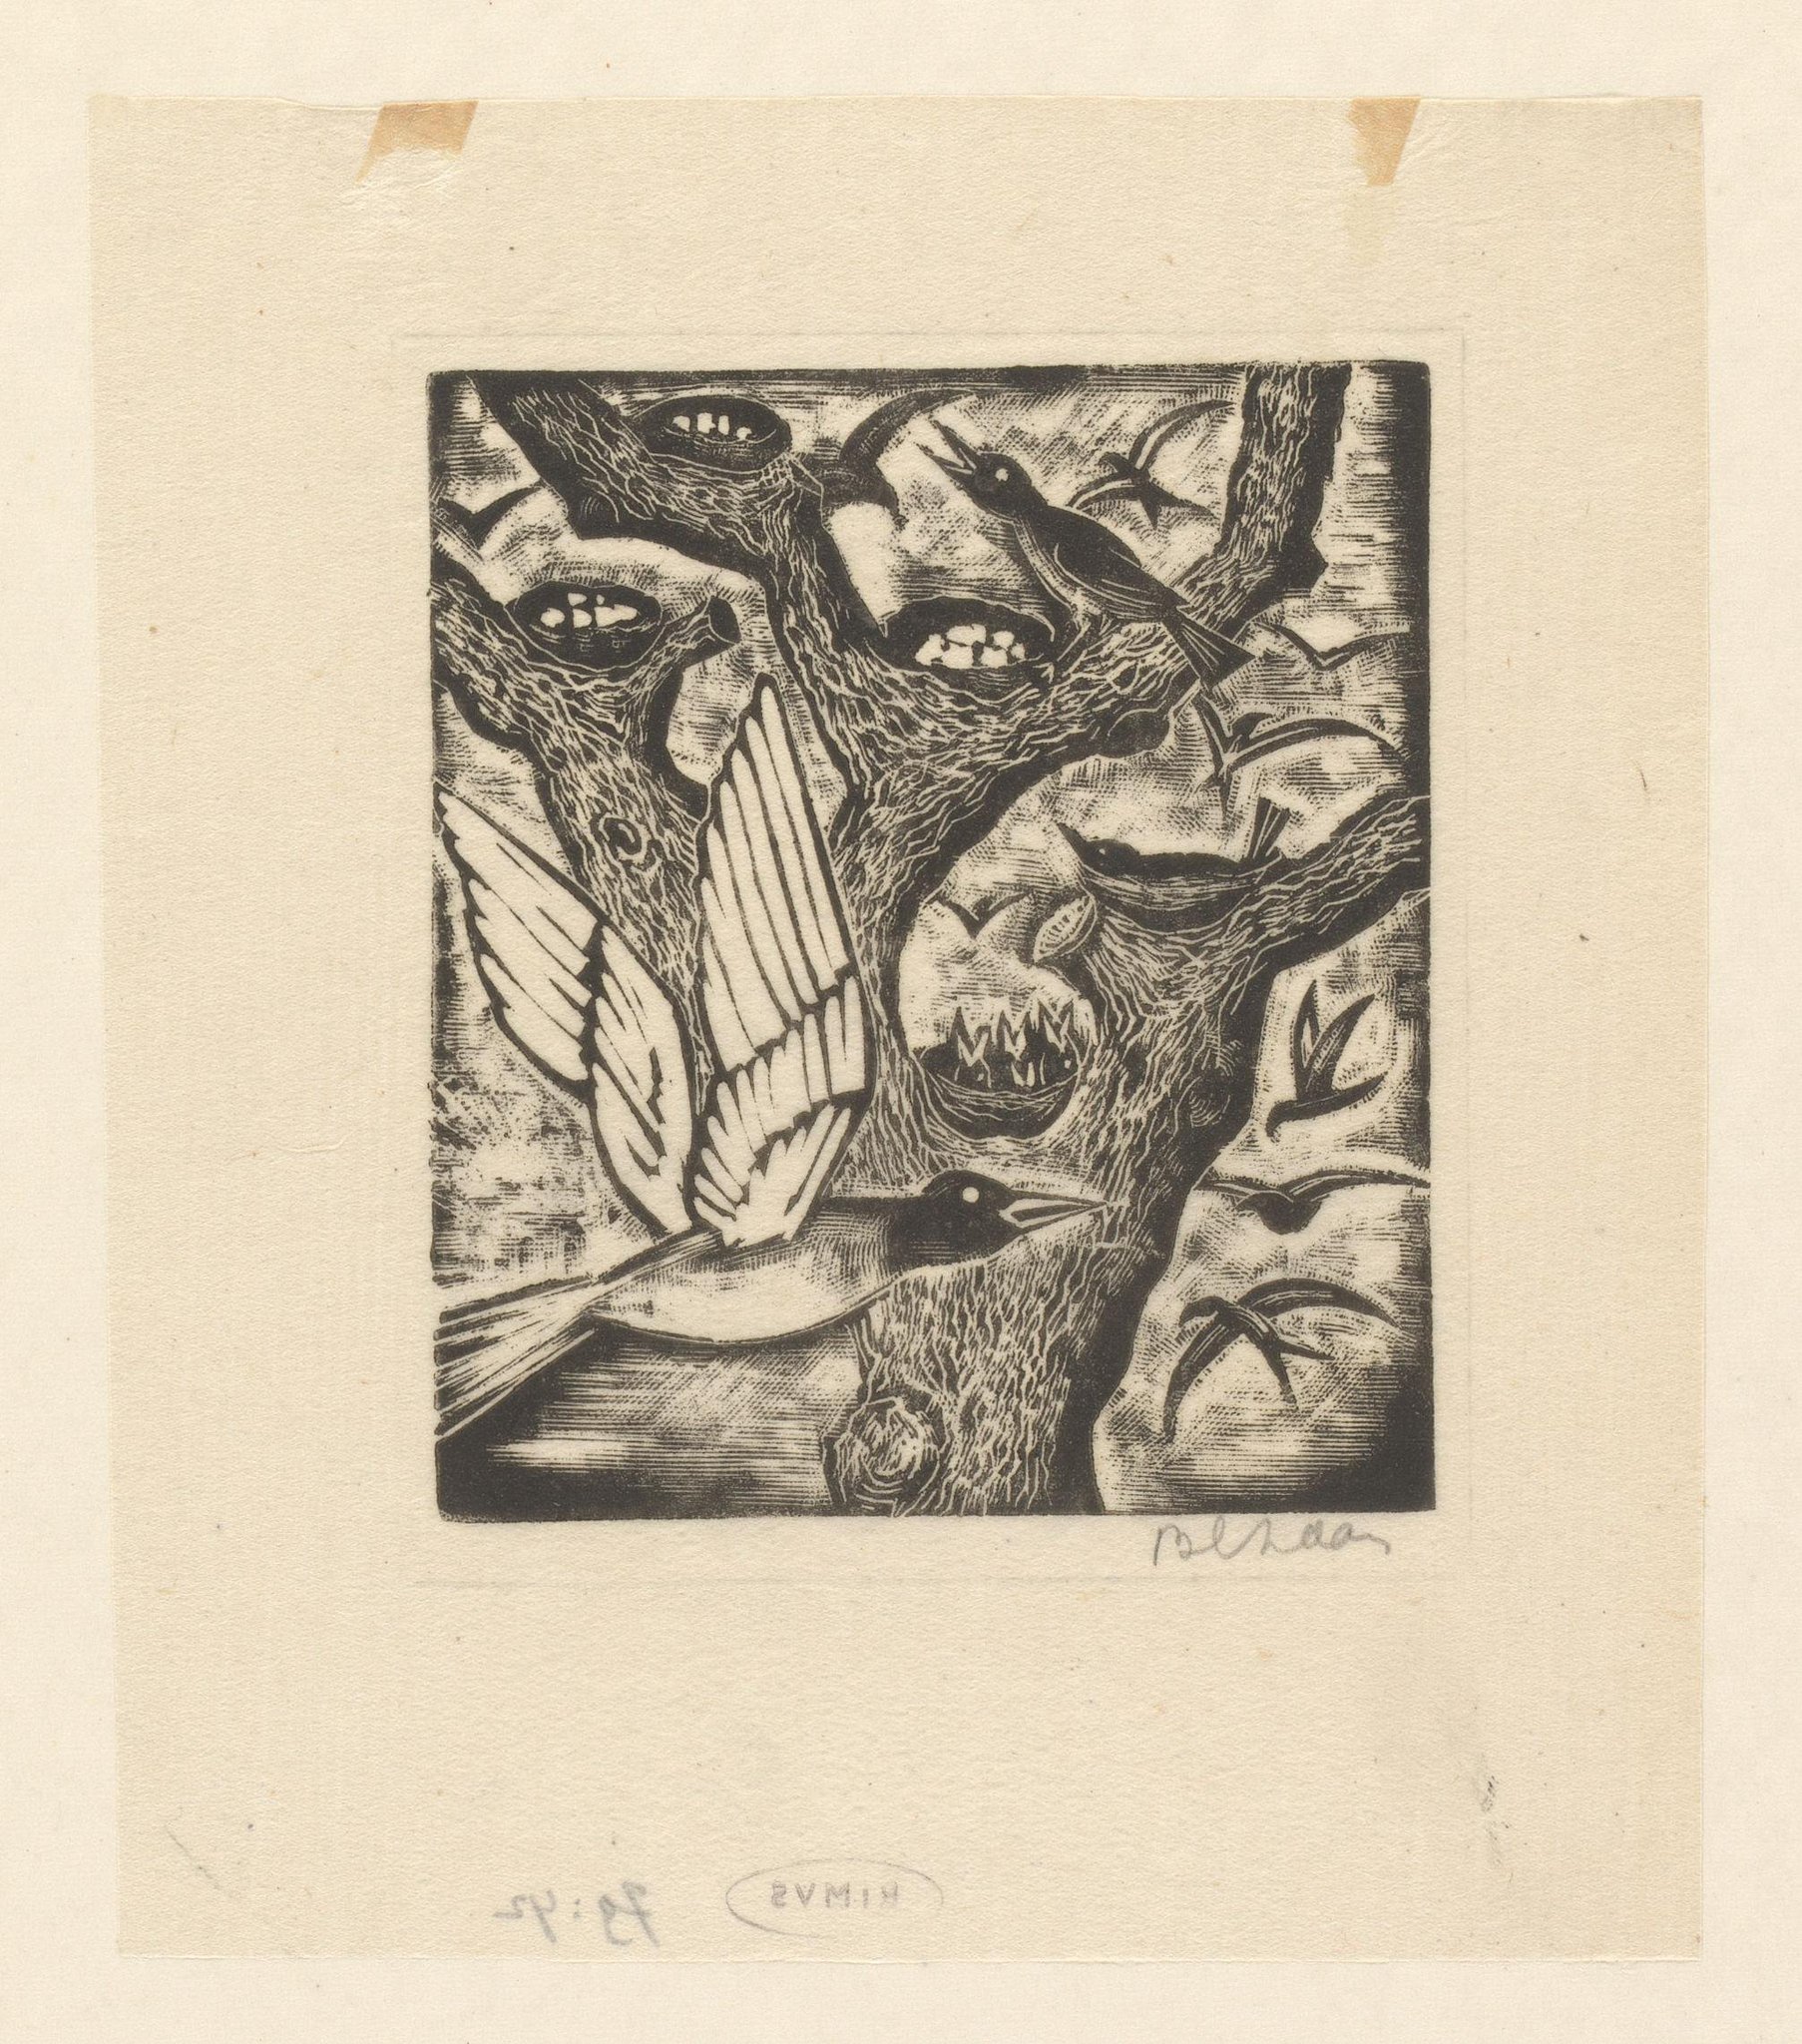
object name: book illustration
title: Diverse vogels bij meerdere nesten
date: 1941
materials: paper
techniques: engraving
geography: putten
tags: birds (+ young animal), groups of birds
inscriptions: collector's mark: Lugt 2228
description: Prent gebruikt voor: Hattum, Jac. van. Van Odrimond, Millimas en anderen. Putten: D.J. Terwee, [1941].